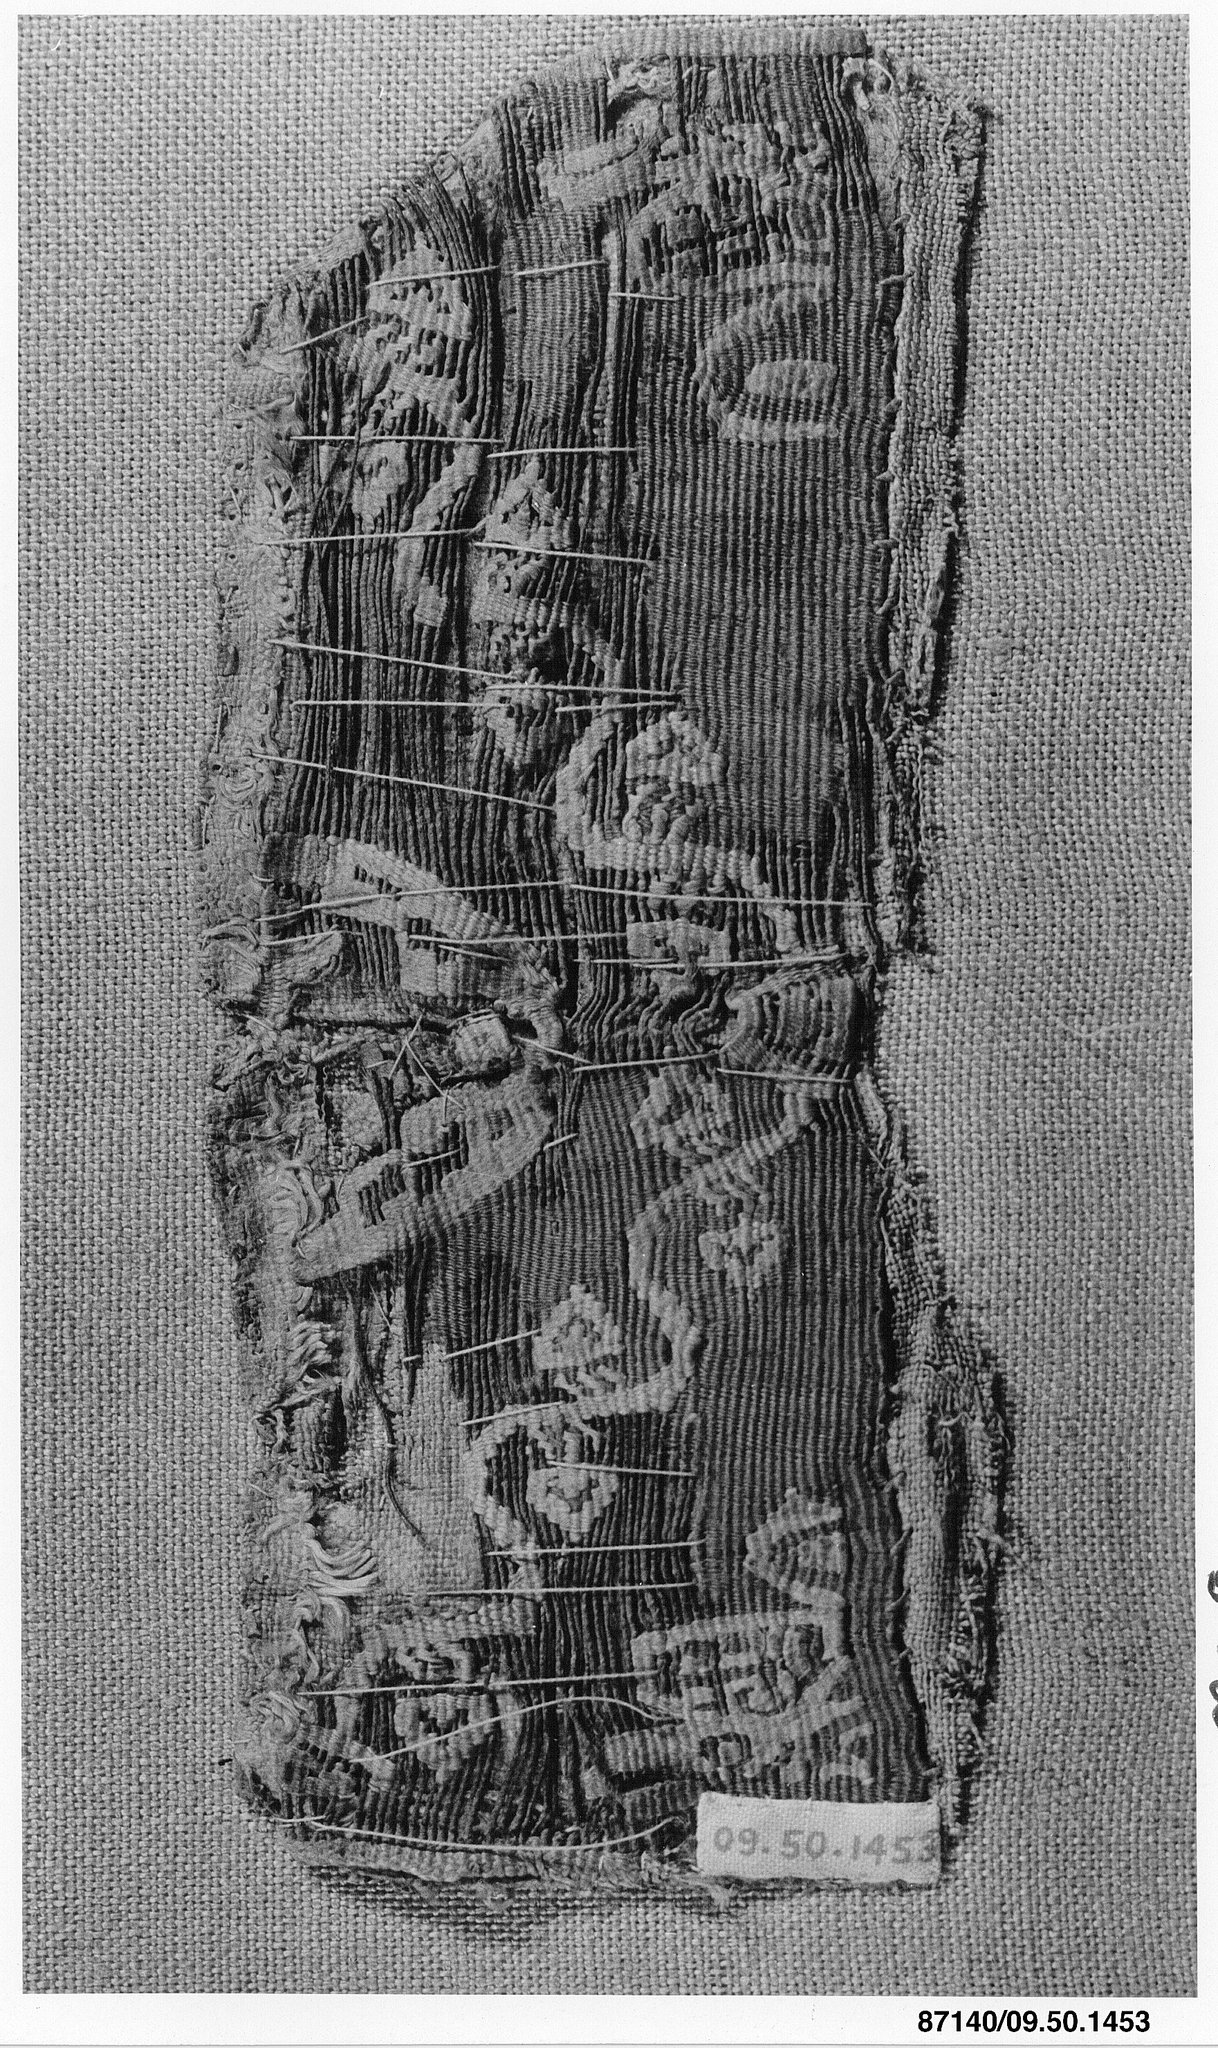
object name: fragment of a sleeve band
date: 401-600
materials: linen, wool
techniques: weave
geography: egypt